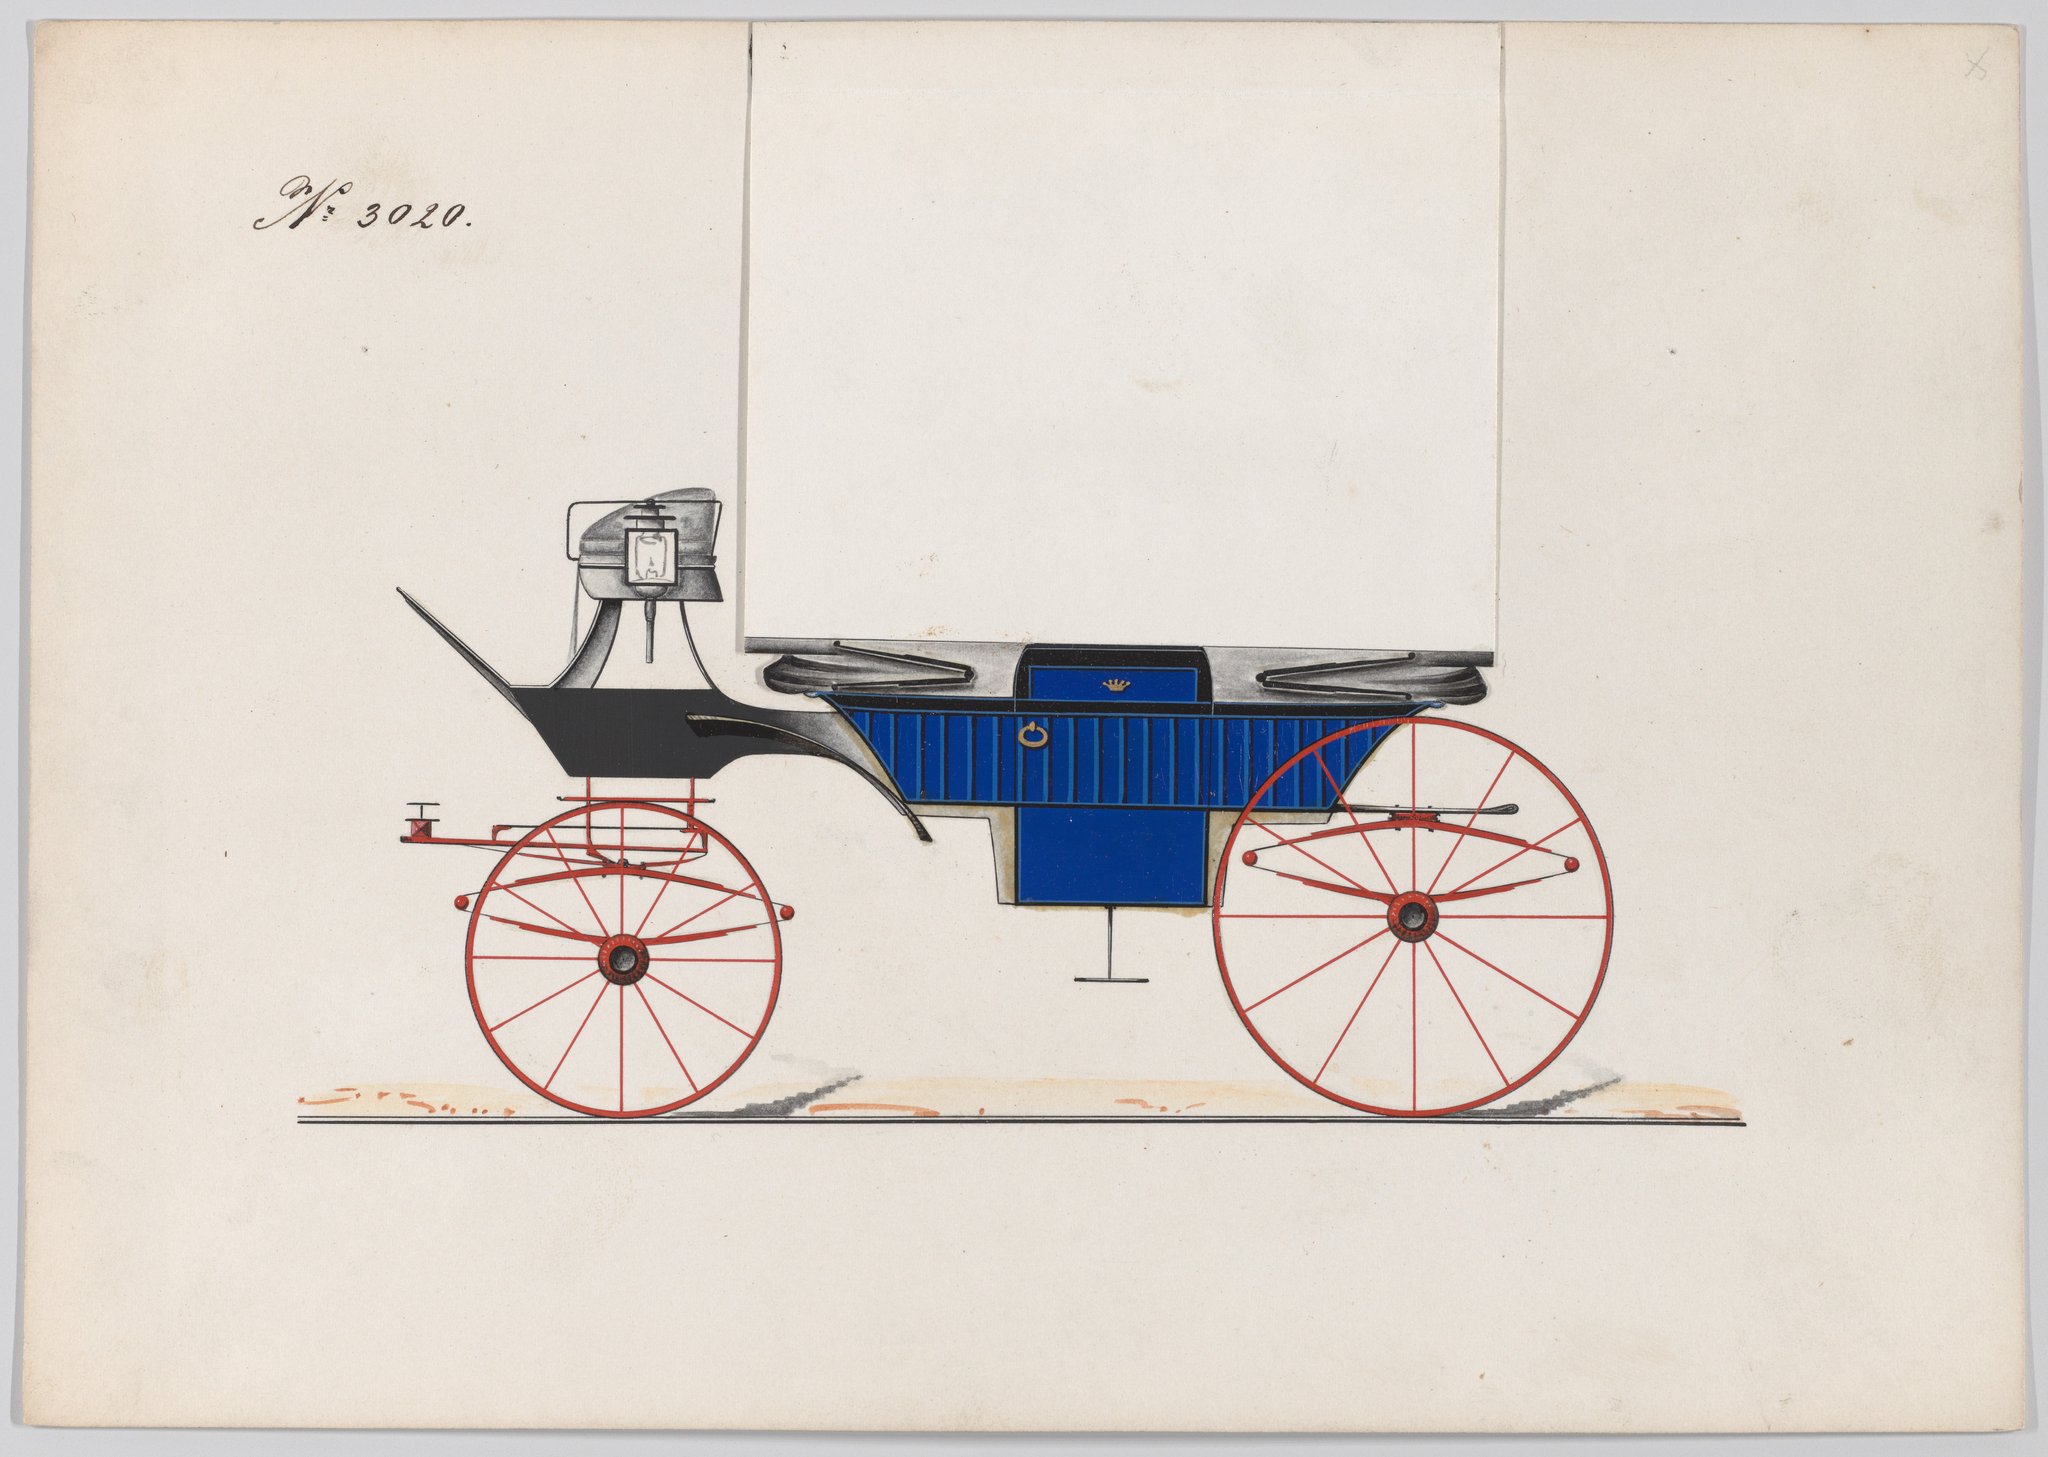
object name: drawing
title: Design for Landau, No. 3006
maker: brewster & co.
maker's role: manufacturer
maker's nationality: american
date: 1874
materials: gouache, gum arabic, ink, watercolor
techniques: pen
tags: carriages